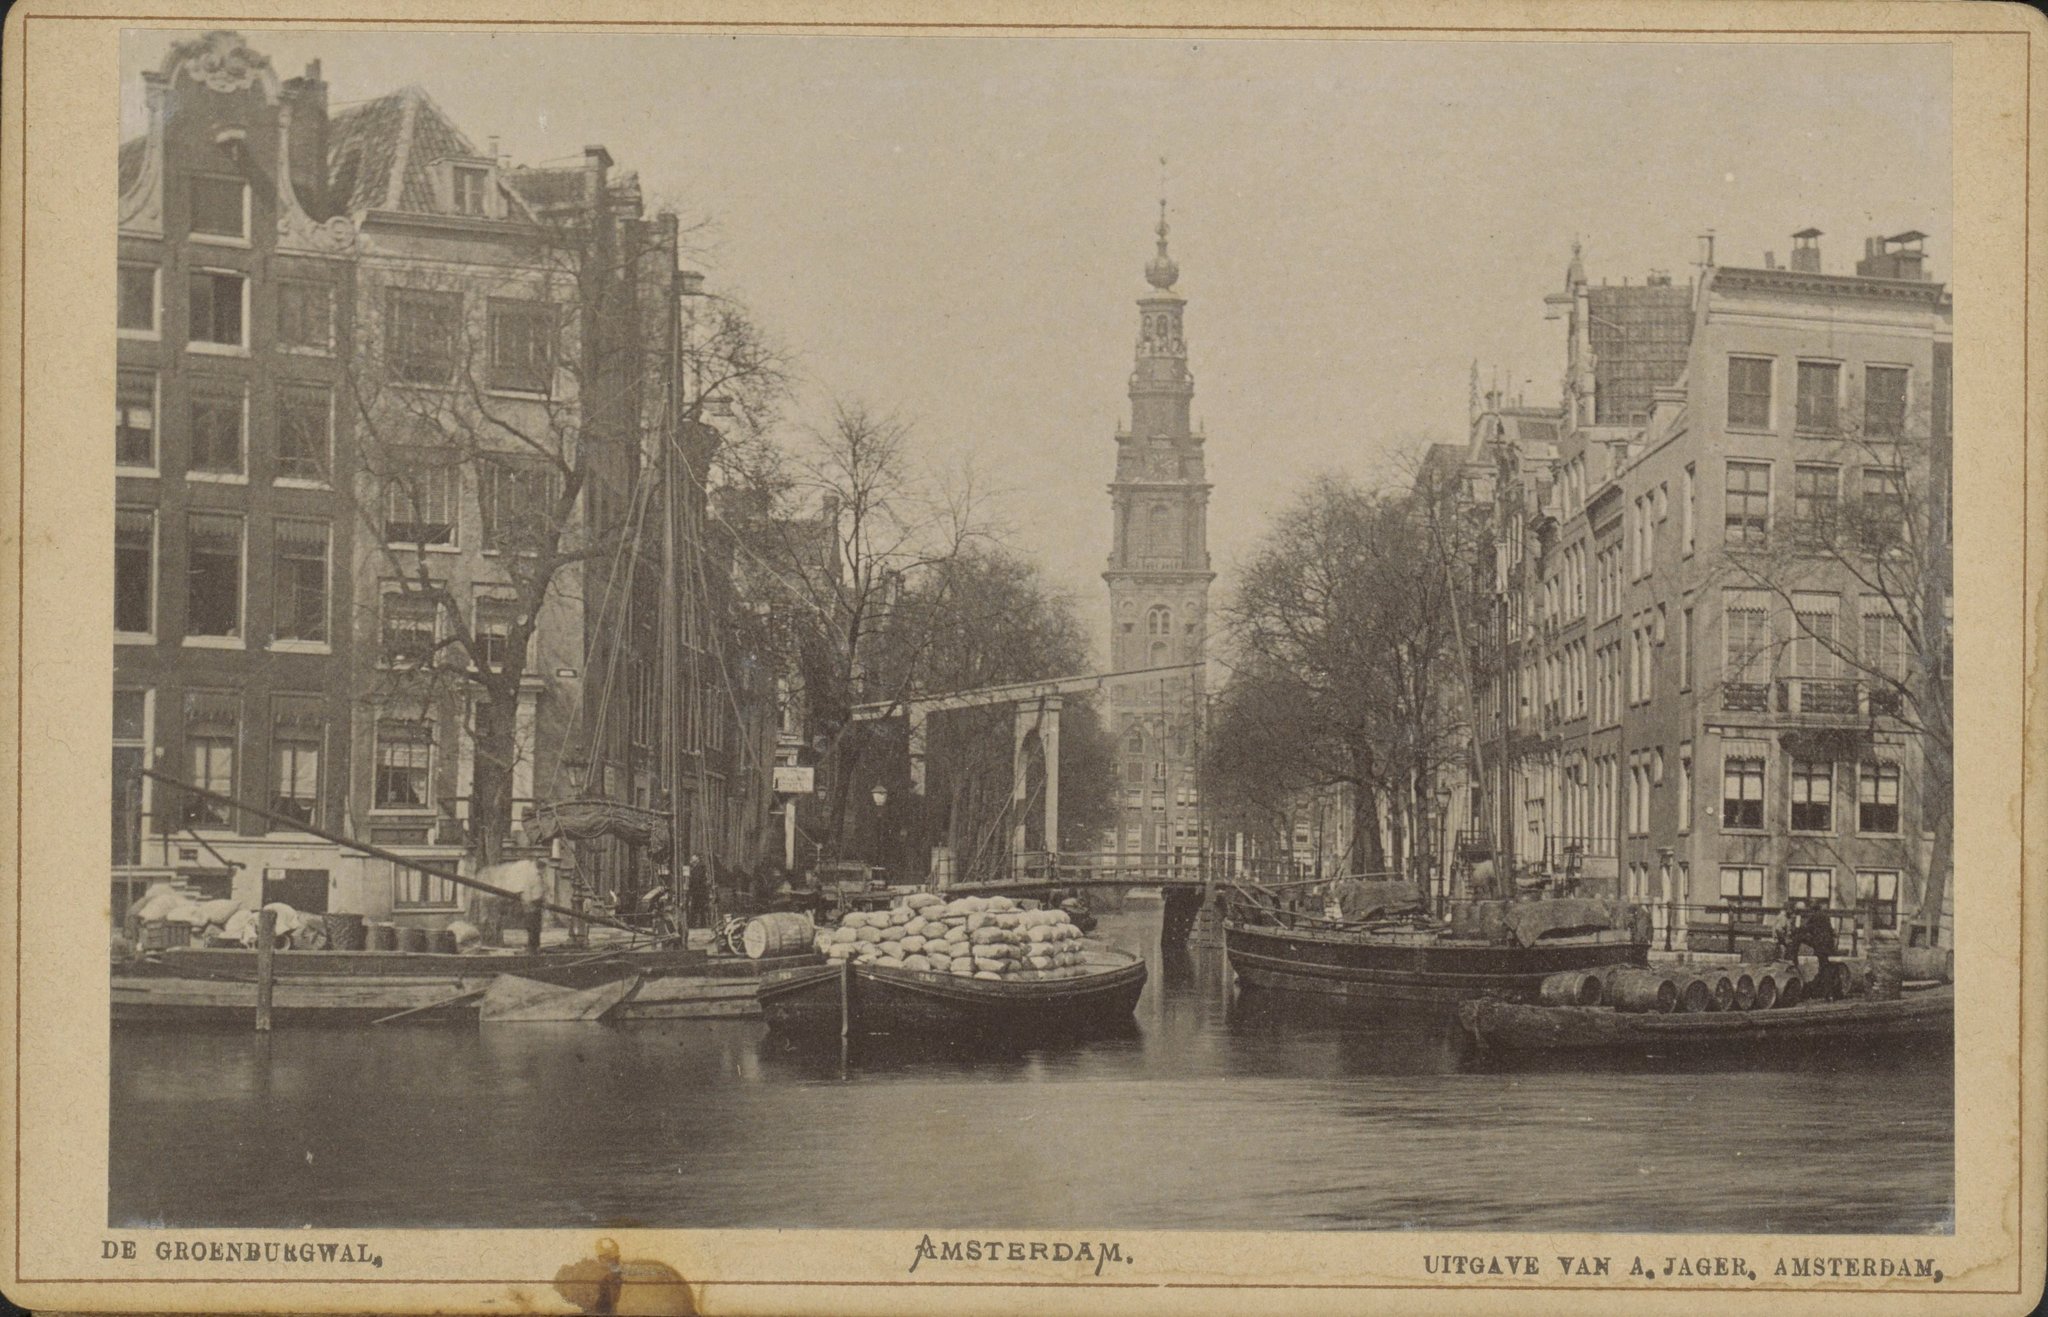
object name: photograph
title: Groenburgwal en Zuiderkerk, gezien vanaf de Amstel, Amsterdam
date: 1880-1895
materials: cardboard, paper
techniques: photograph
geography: amsterdam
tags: zuiderkerk, groenburgwal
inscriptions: inscription: ‘DE GROENBURGWAL. AMSTERDAM. UITGAVE VAN A. JAGER, AMSTERDAM,’